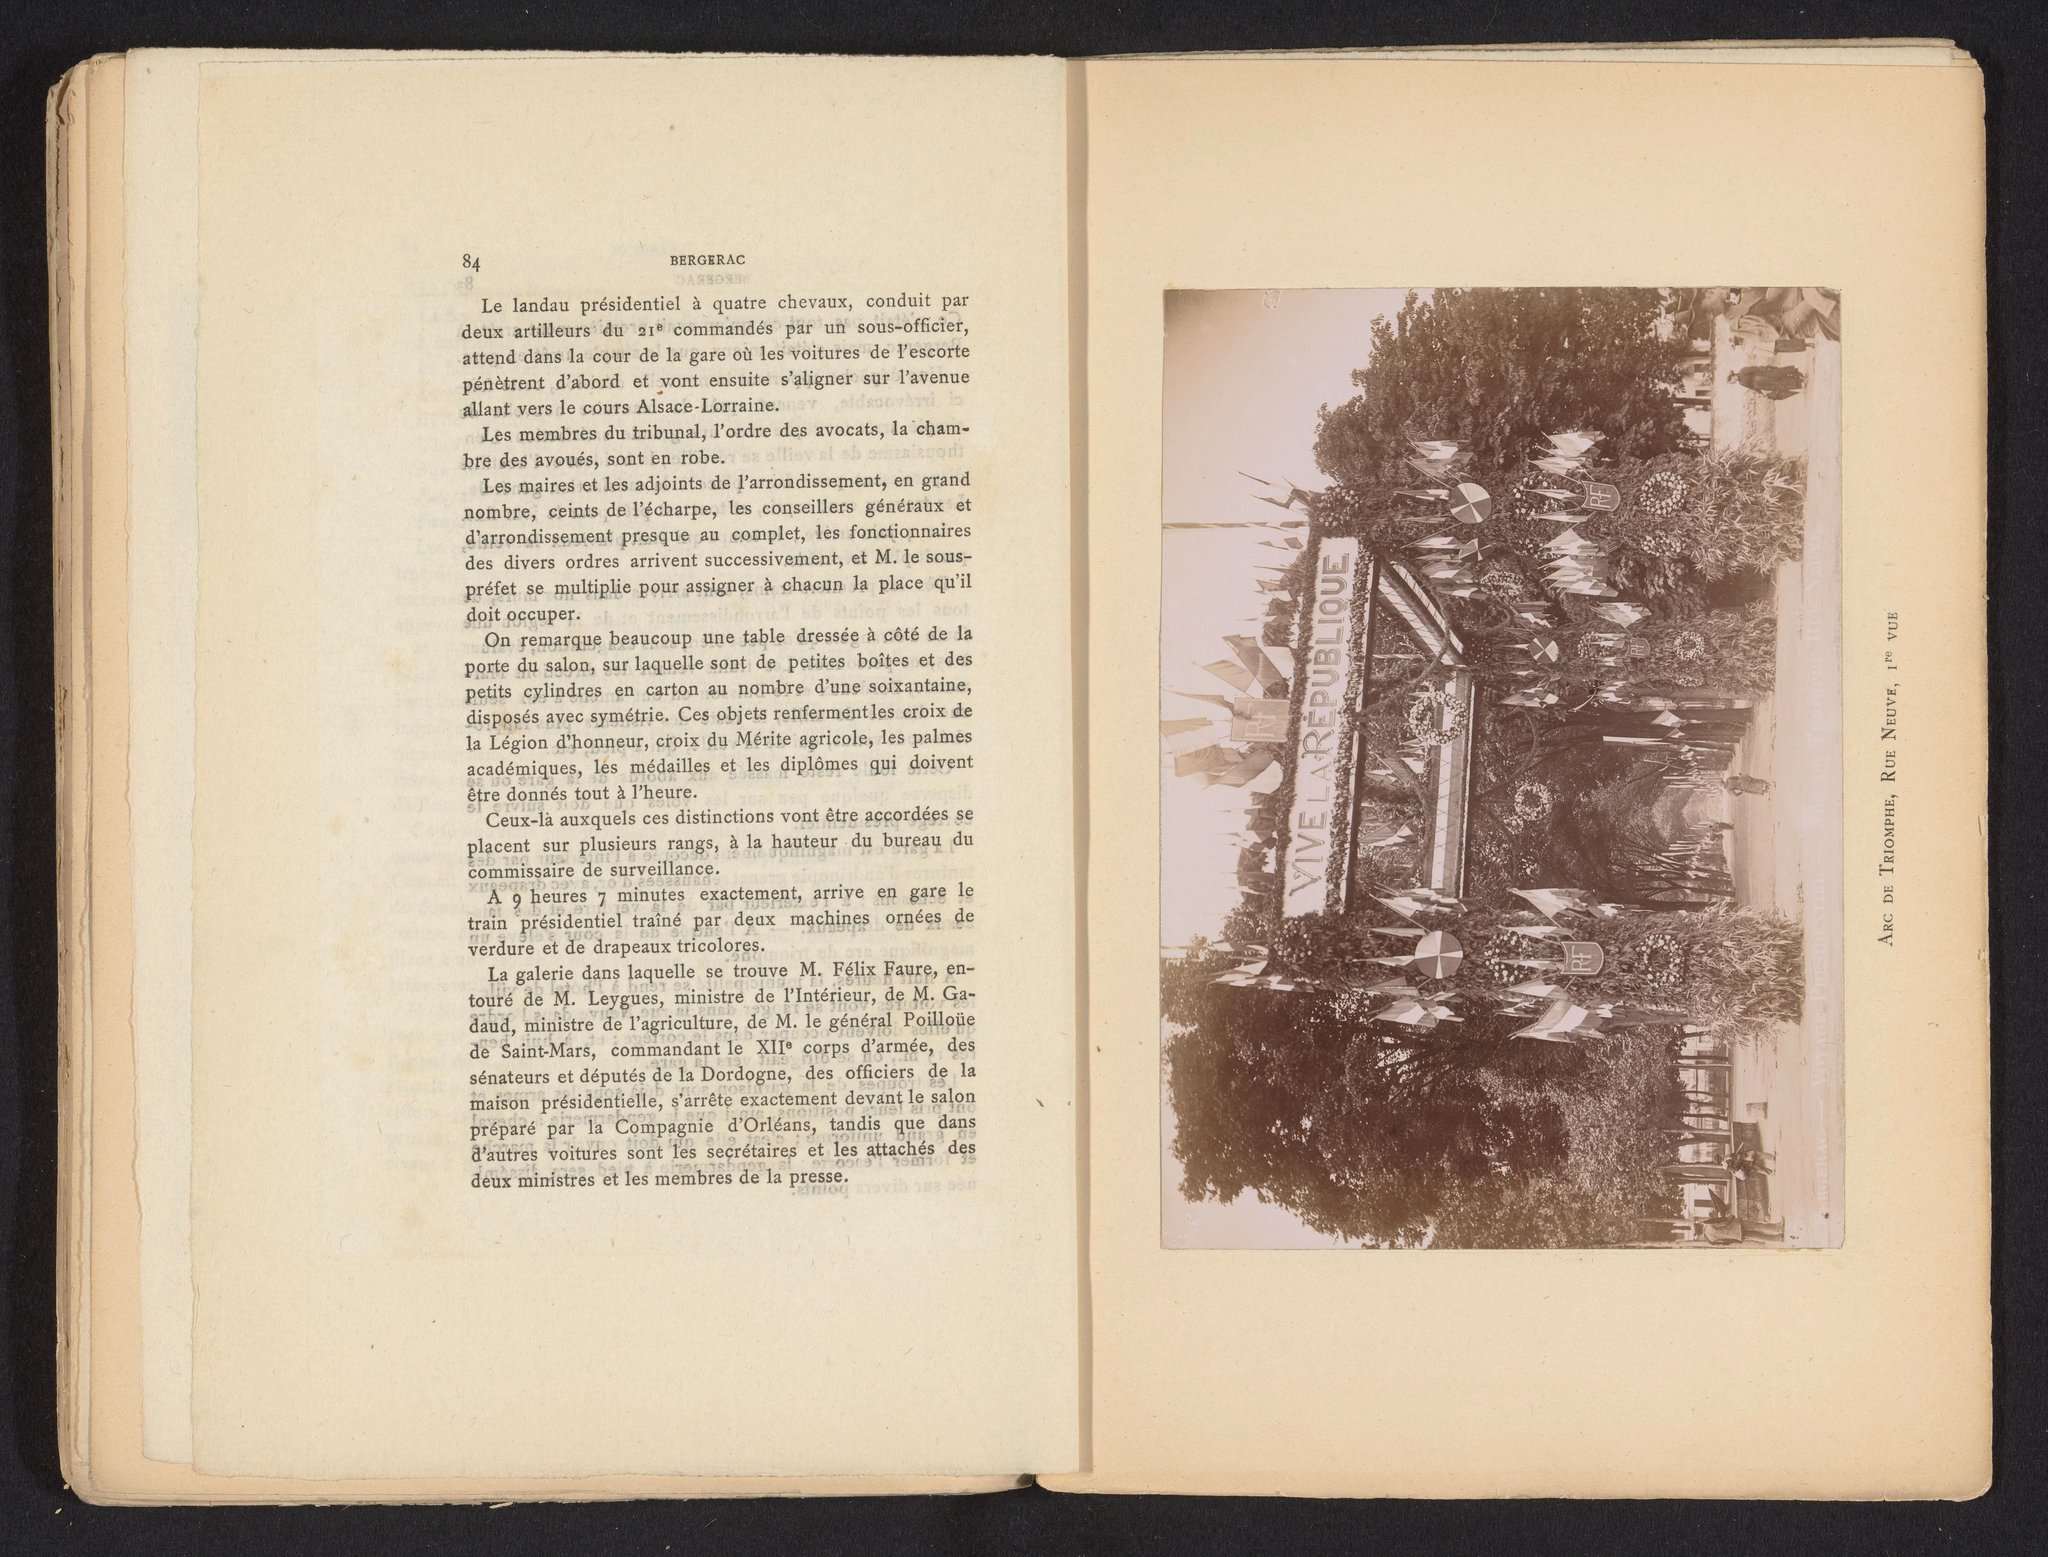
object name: page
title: Bergerac- Voyage presidentiel- Arc de triomphe, Rue Neuve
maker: Anonymous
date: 1895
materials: photographic support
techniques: gelatin silver print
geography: bergerac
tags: triumphal arch, triumphal entry and public reception, pageant, 'entrée solennelle', 'joyeuse entrée', street